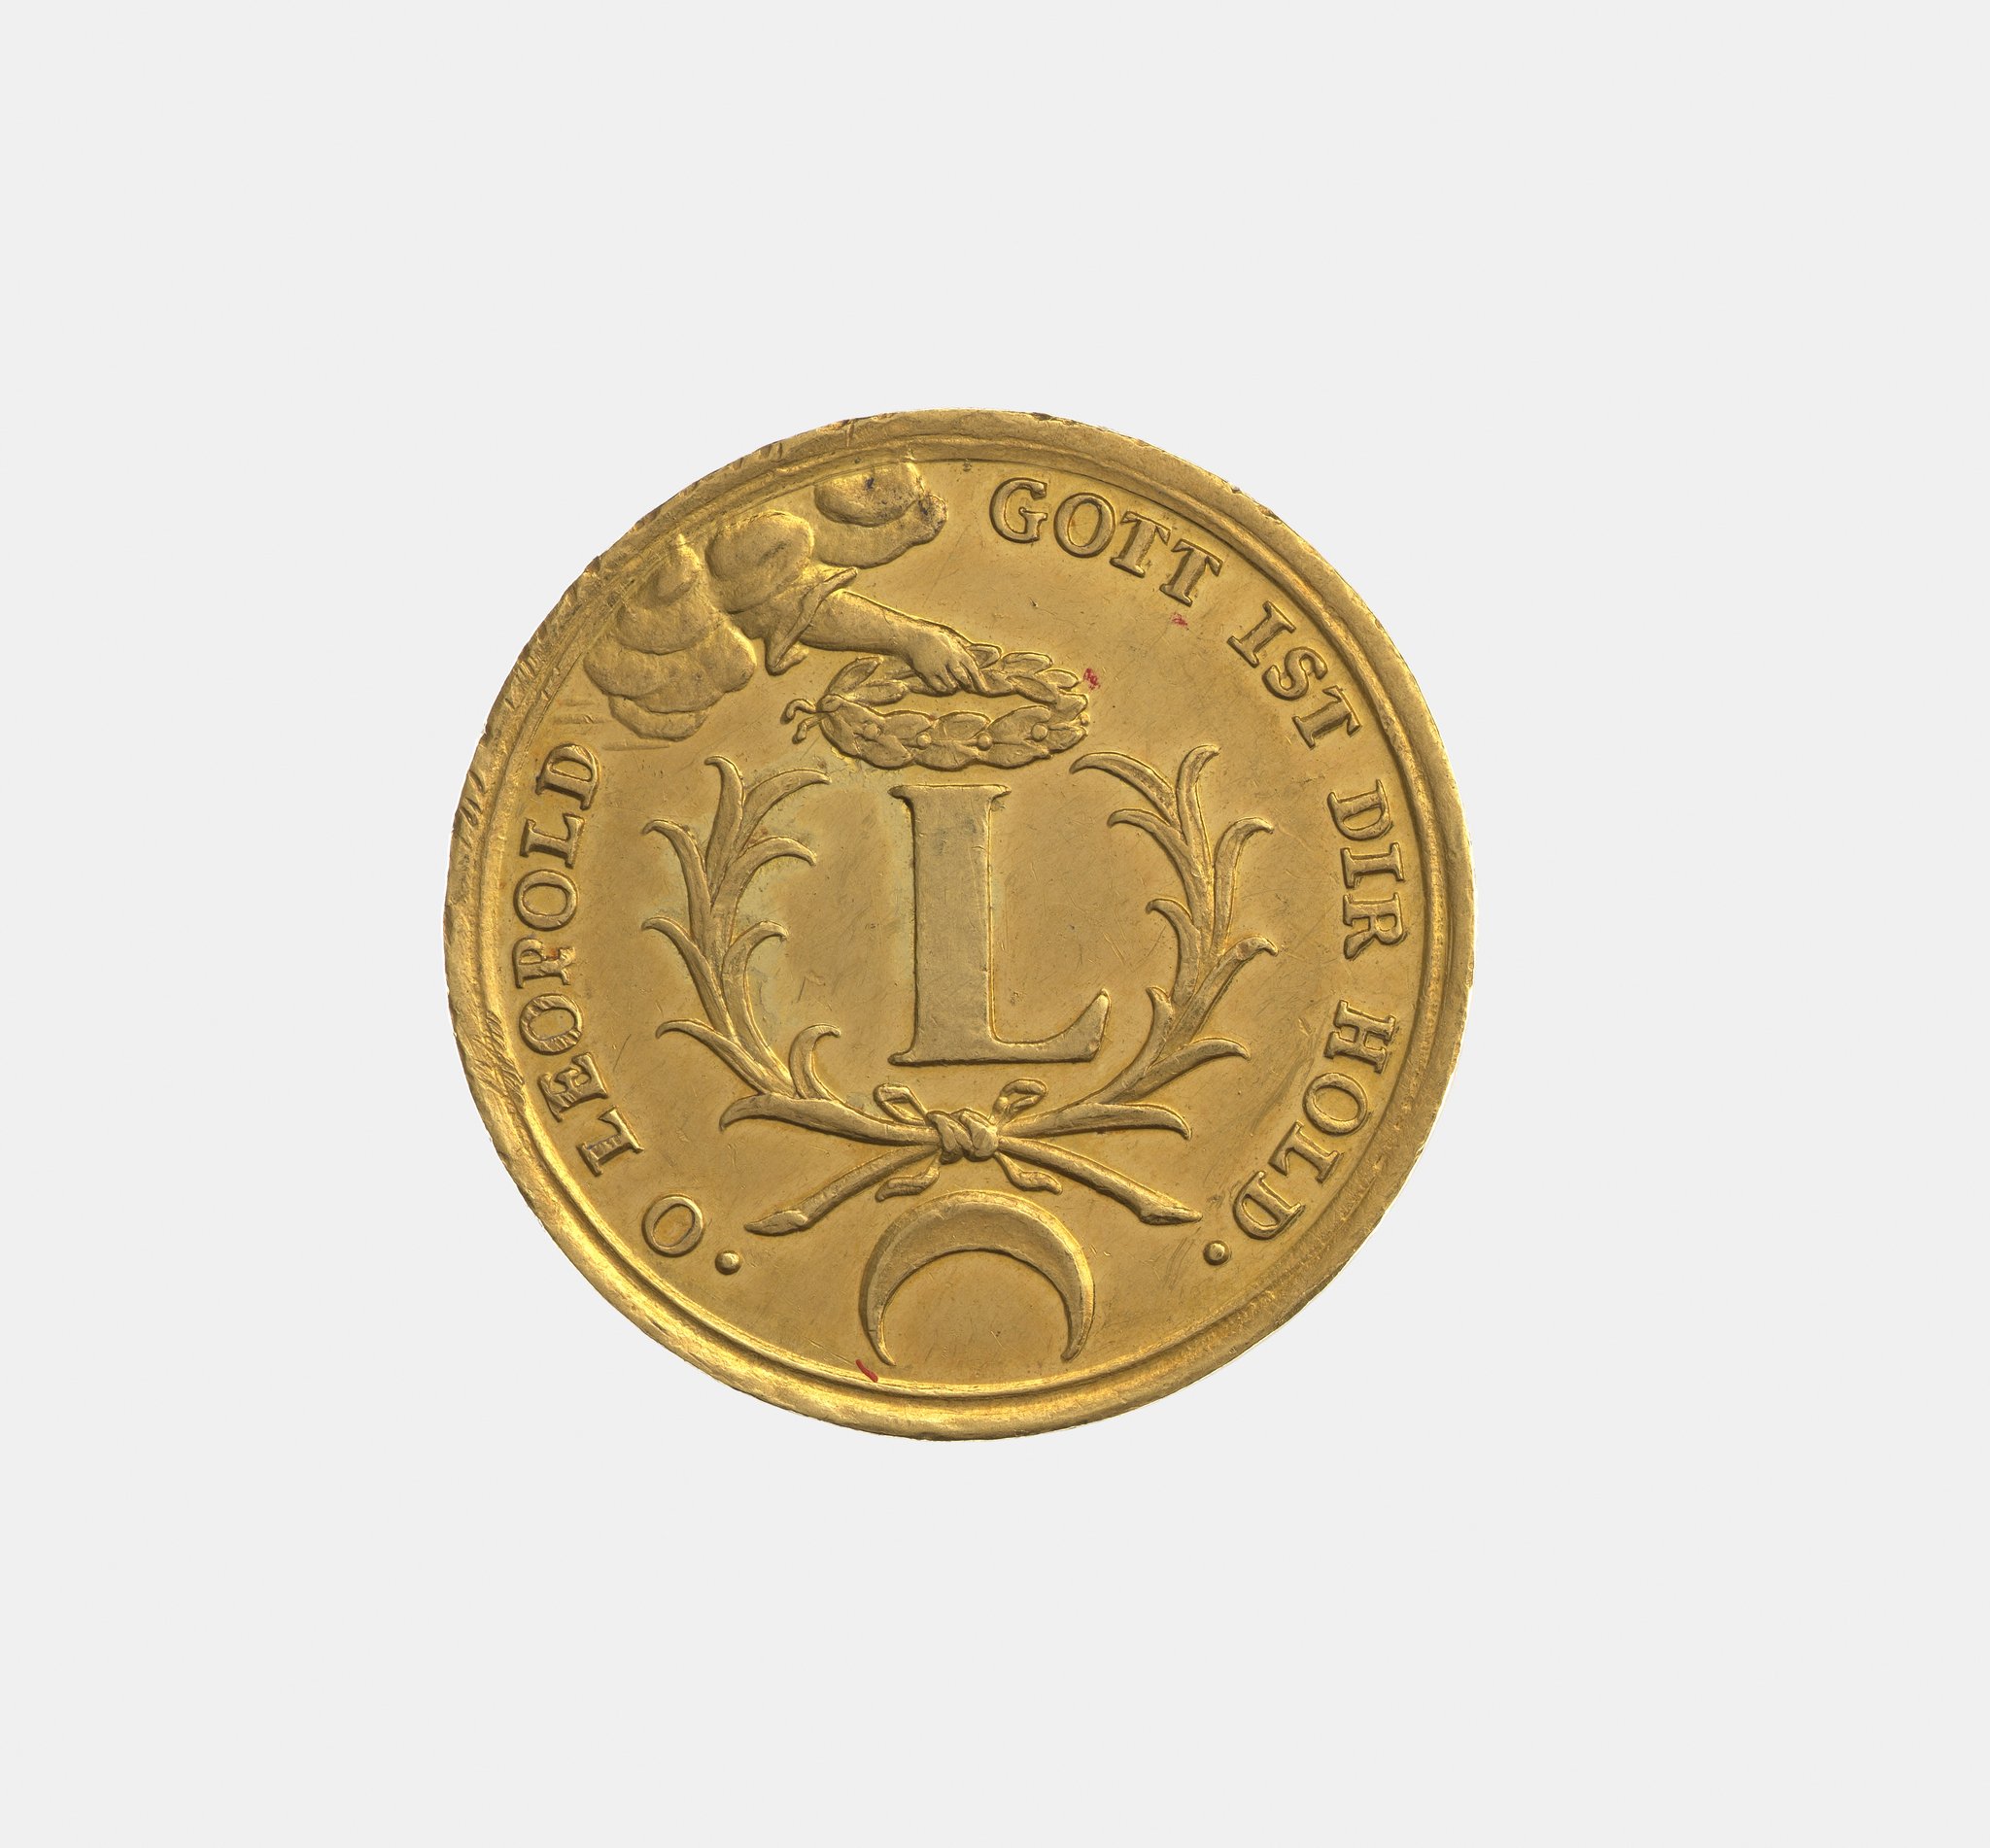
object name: double ducat medal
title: Leopold I (1658–1705) / Relief of Vienna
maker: Anonymous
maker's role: artist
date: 1683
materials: gold